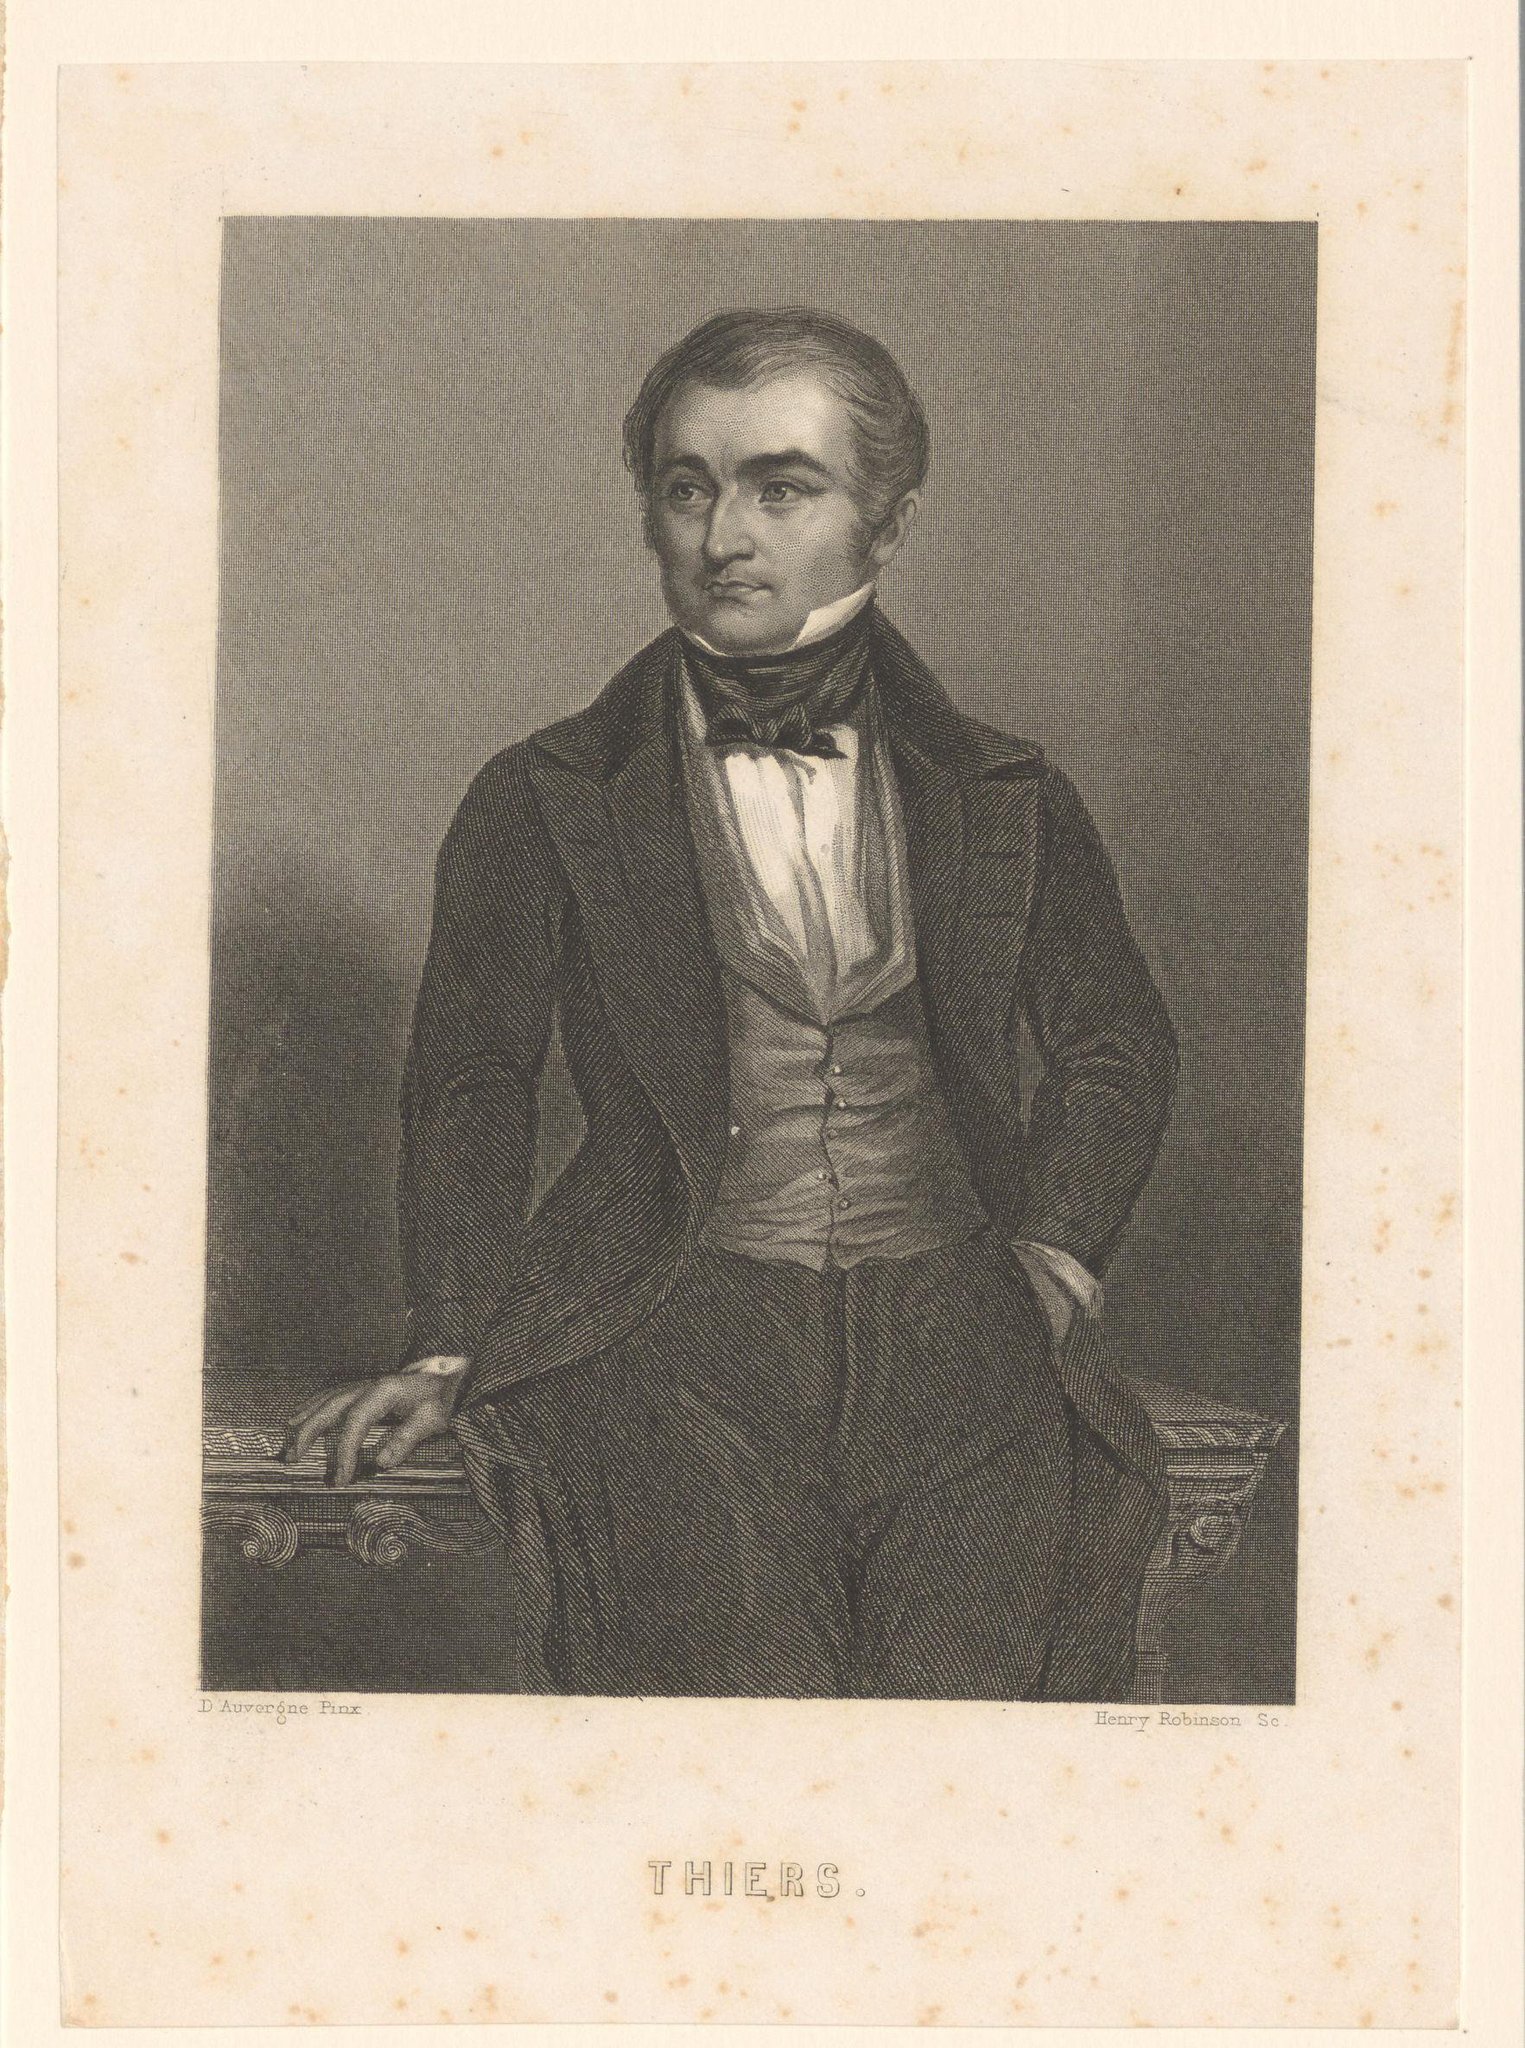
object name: print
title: Portret van Adolphe Thiers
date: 1806-1871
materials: paper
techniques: etching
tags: politician, historical persons, politician, e.g. party leader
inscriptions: collector's mark: Lugt 2228